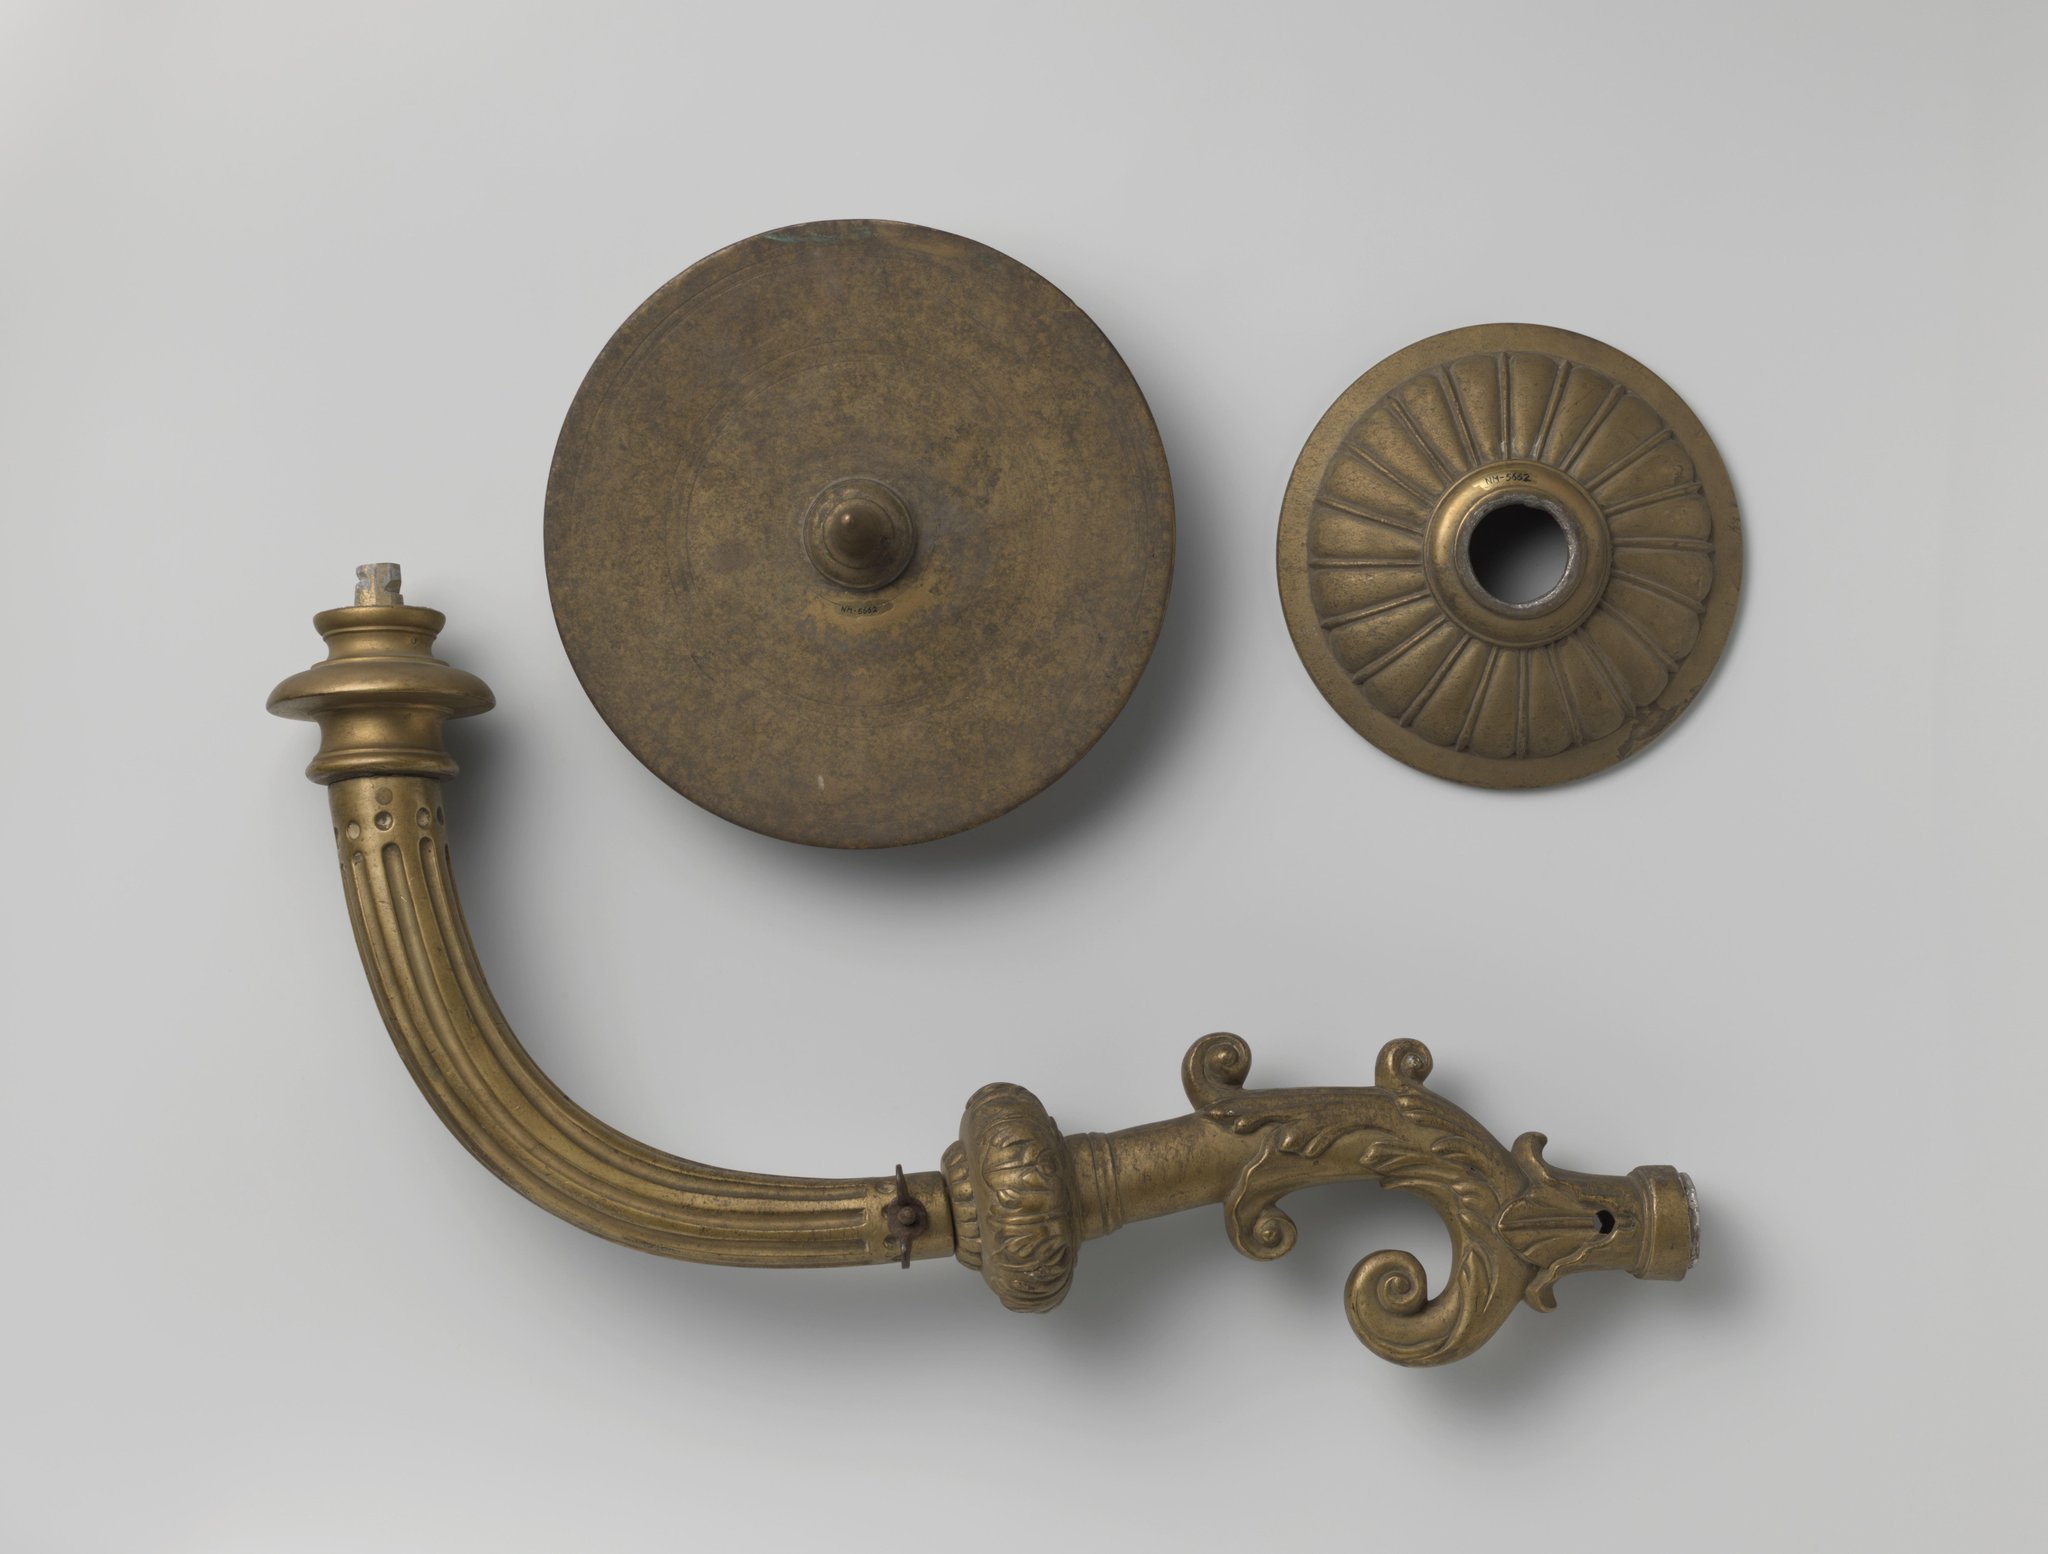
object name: lichtarm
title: Vetvanger van lichtarm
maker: Anonymous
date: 1590-1610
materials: brass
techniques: casting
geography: mechelen